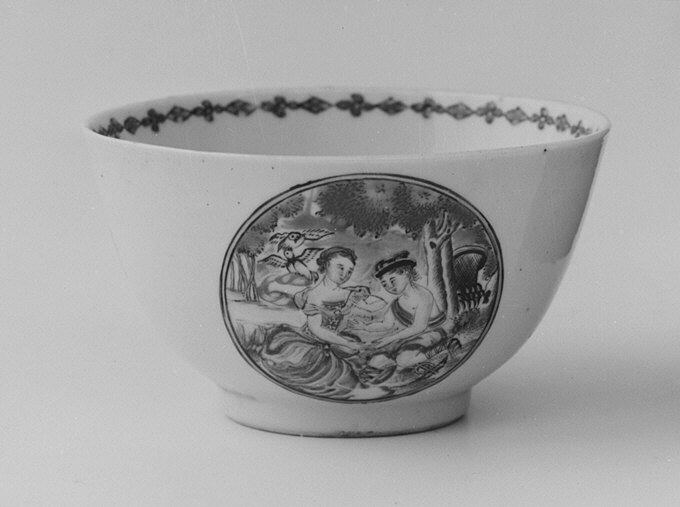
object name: teacup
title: Tea cup (part of a service)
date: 1750-1770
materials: hard paste porcelain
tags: birds,men,women